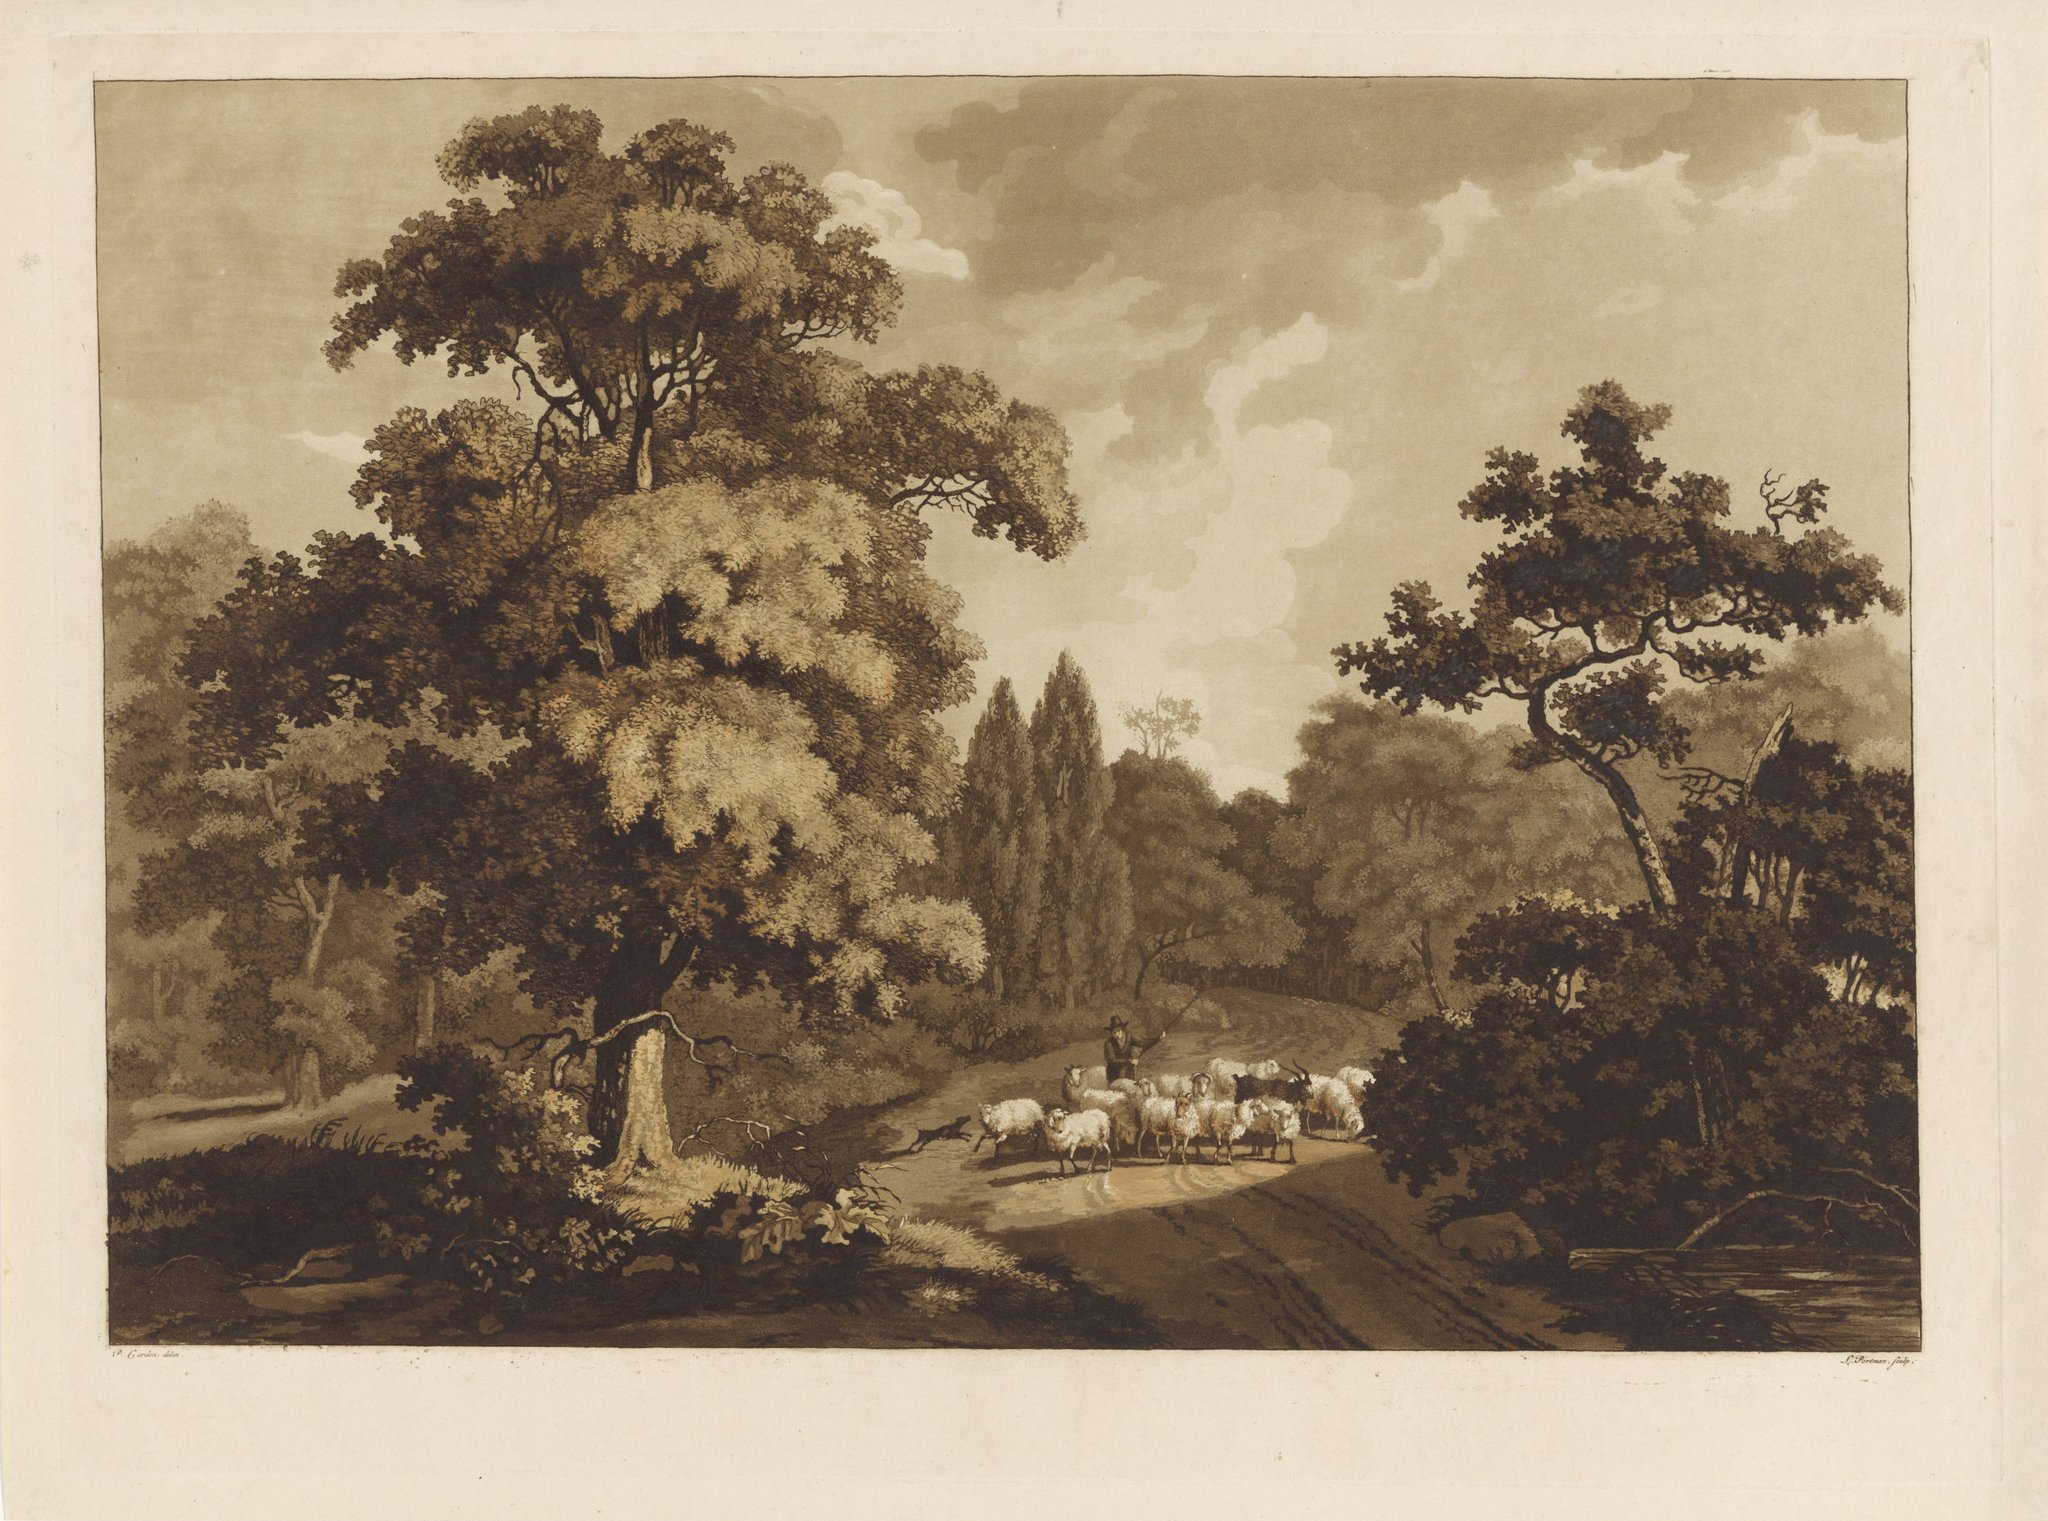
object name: print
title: Landschap met schapenherder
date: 1787-1828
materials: paper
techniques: aquatint, brush, etching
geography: northern netherlands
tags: herding, herdsman, herdswoman, shepherd, shepherdess, cowherd, etc.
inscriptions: collector's mark: Lugt 2228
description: Op een pad in het bos loopt een schapenherder te midden van zijn kudde. Hij drijft de schapen voort met een stok.